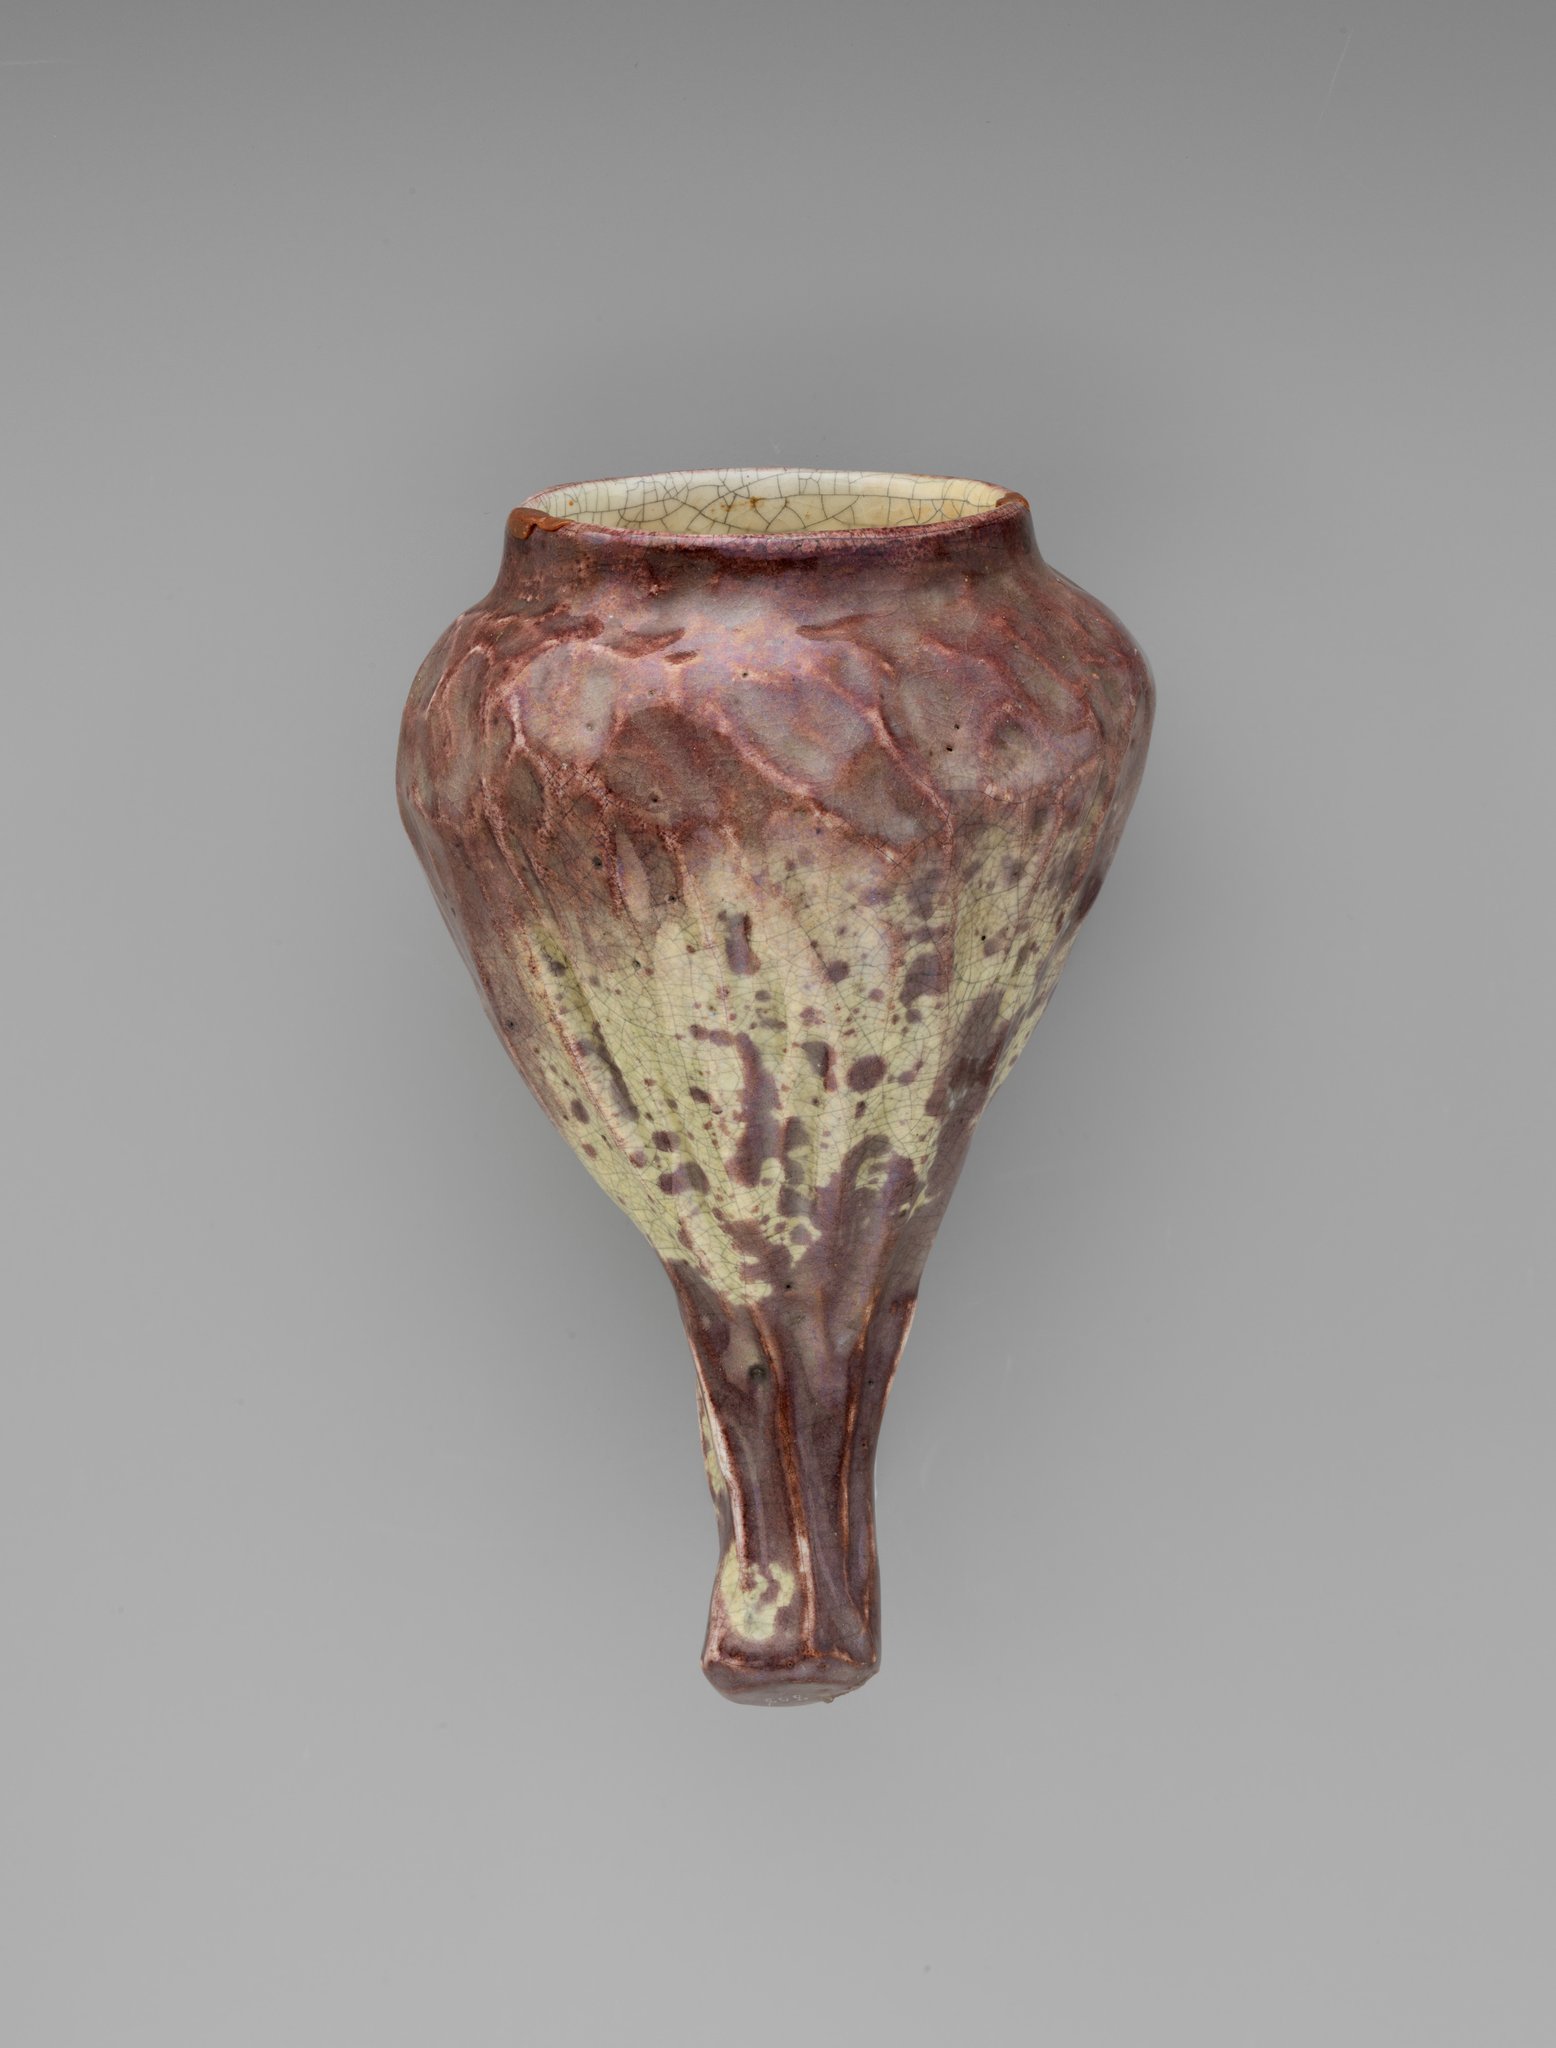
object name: hanging vase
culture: japanese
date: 1834-1866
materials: copper, earthenware, glaze, lead